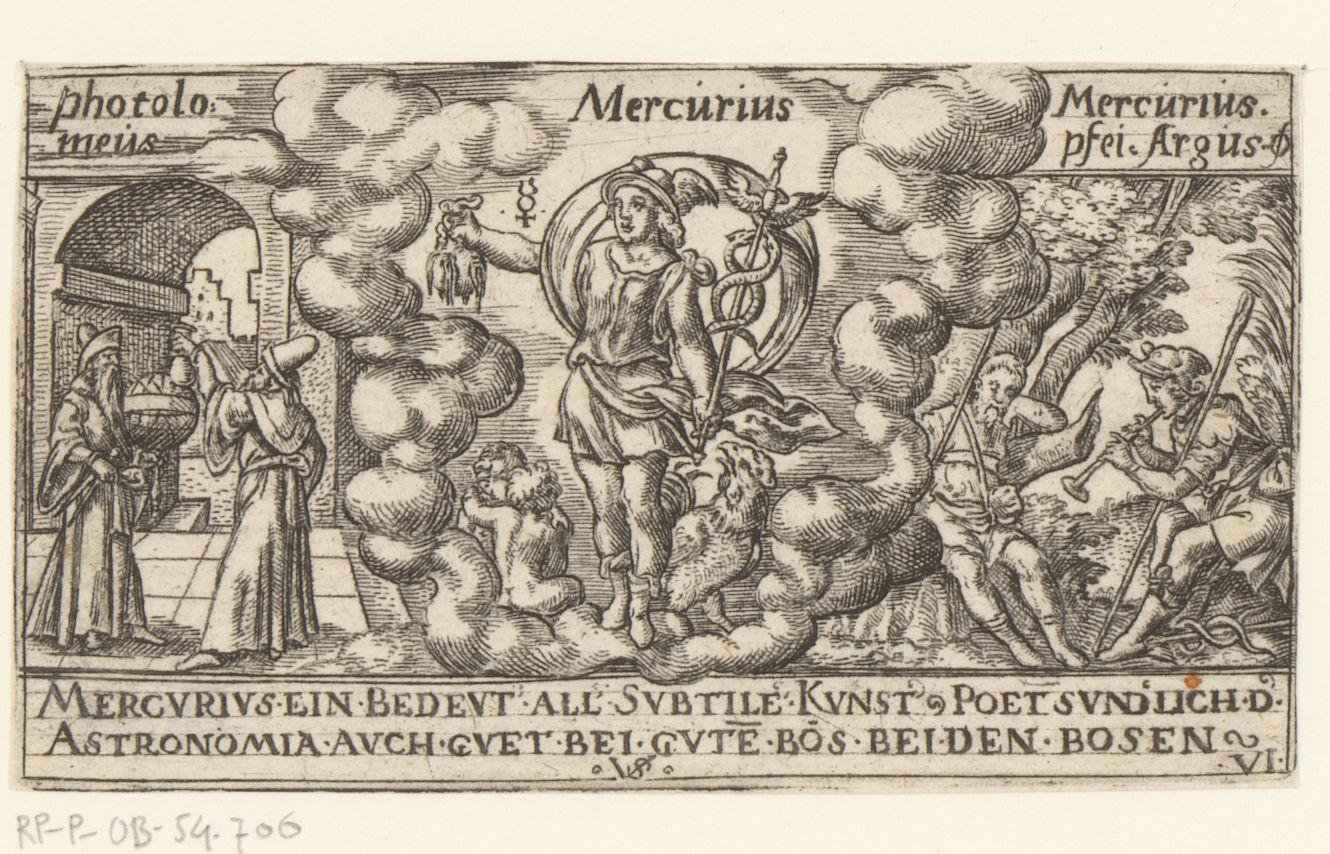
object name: print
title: Mercurius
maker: virgilius solis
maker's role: draughtsman, print maker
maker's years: 1514-1562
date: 1524-1562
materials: paper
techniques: engraving, etching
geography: nuremberg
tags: virgo (zodiacal sign of august), mercury lulls argus into sleep by making music, (story of) mercury (hermes), gemini (zodiacal sign of may), mercury (planet)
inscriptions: number: ‘52’, collector's mark: Lugt 2228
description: Maakt deel uit van een serie van zeven prenten met personificaties van de planeten, tekens van de dierenriem en verbeeldingen van verhalen uit de Metamorfosen van Ovidius.